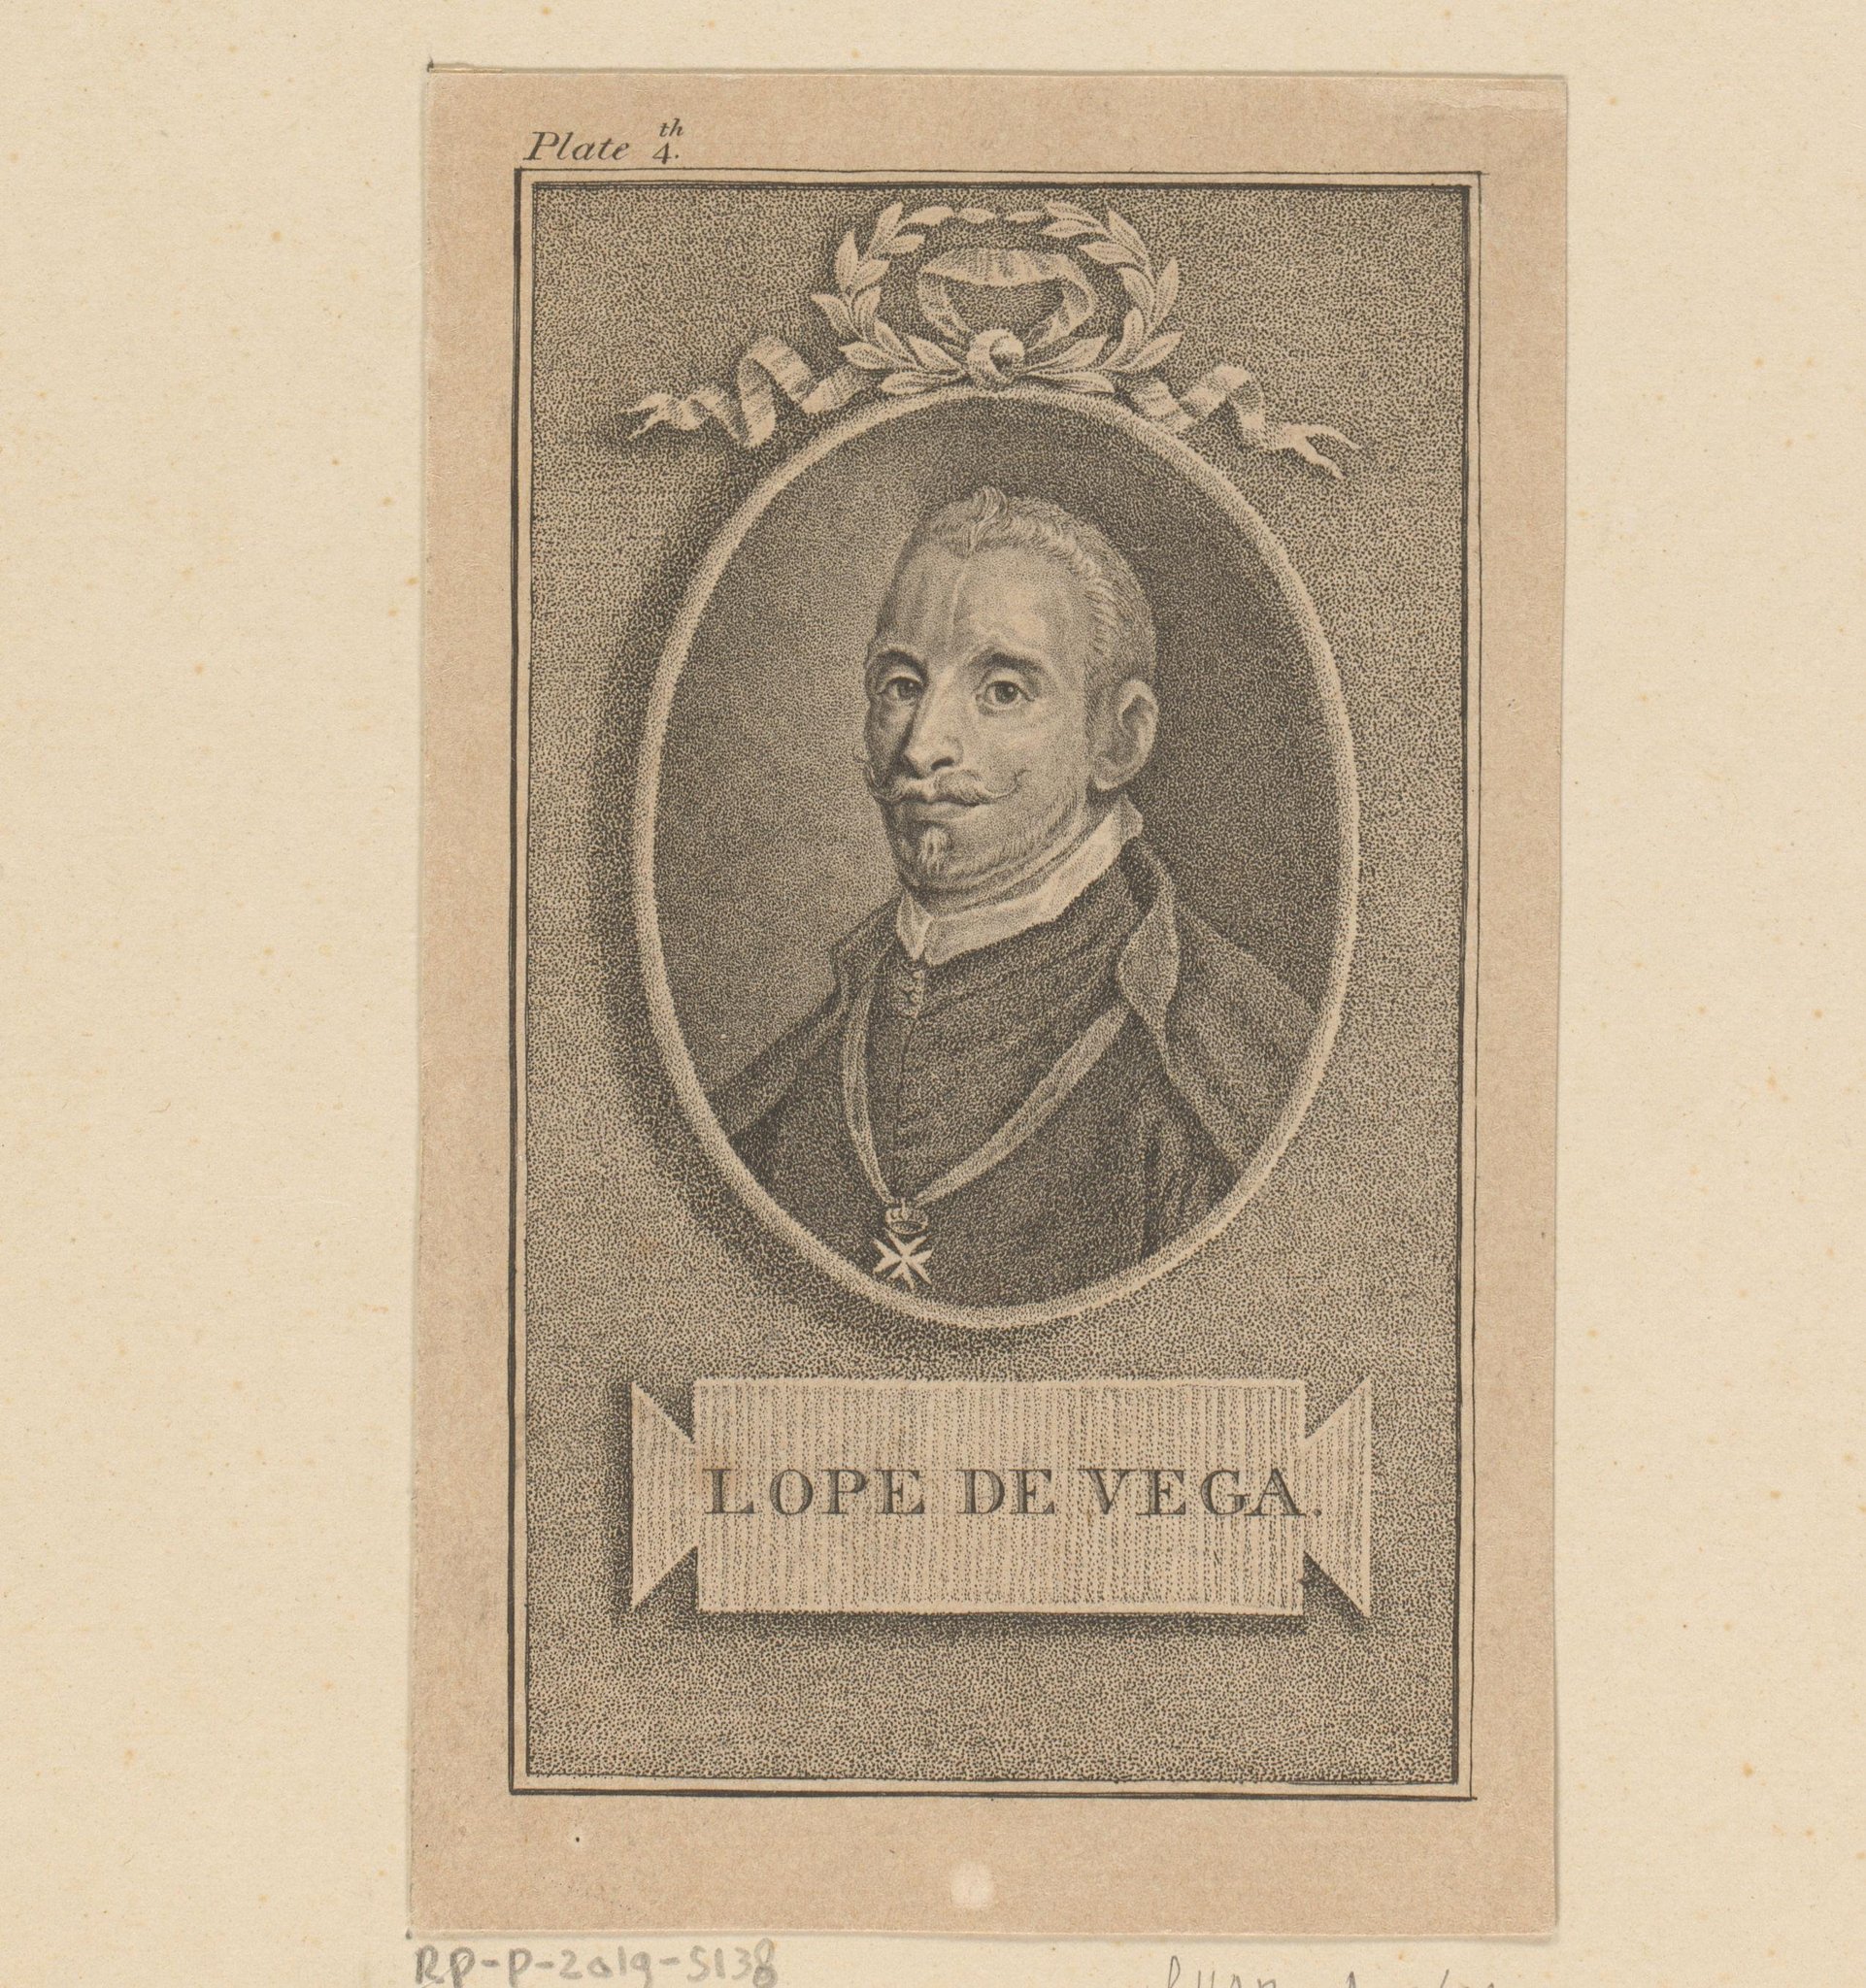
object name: print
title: Portret van Félix Lope de Vega Carpio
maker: robert hancock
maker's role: painter, print maker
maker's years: 1730-1817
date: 1746-1817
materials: paper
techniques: engraving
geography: england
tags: historical persons, portrait of a writer, writer, poet, author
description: Portret in een ovaal bekroond met linten en lauwerkrans. De geportretteerde draagt een ketting met een Maltezer kruis.